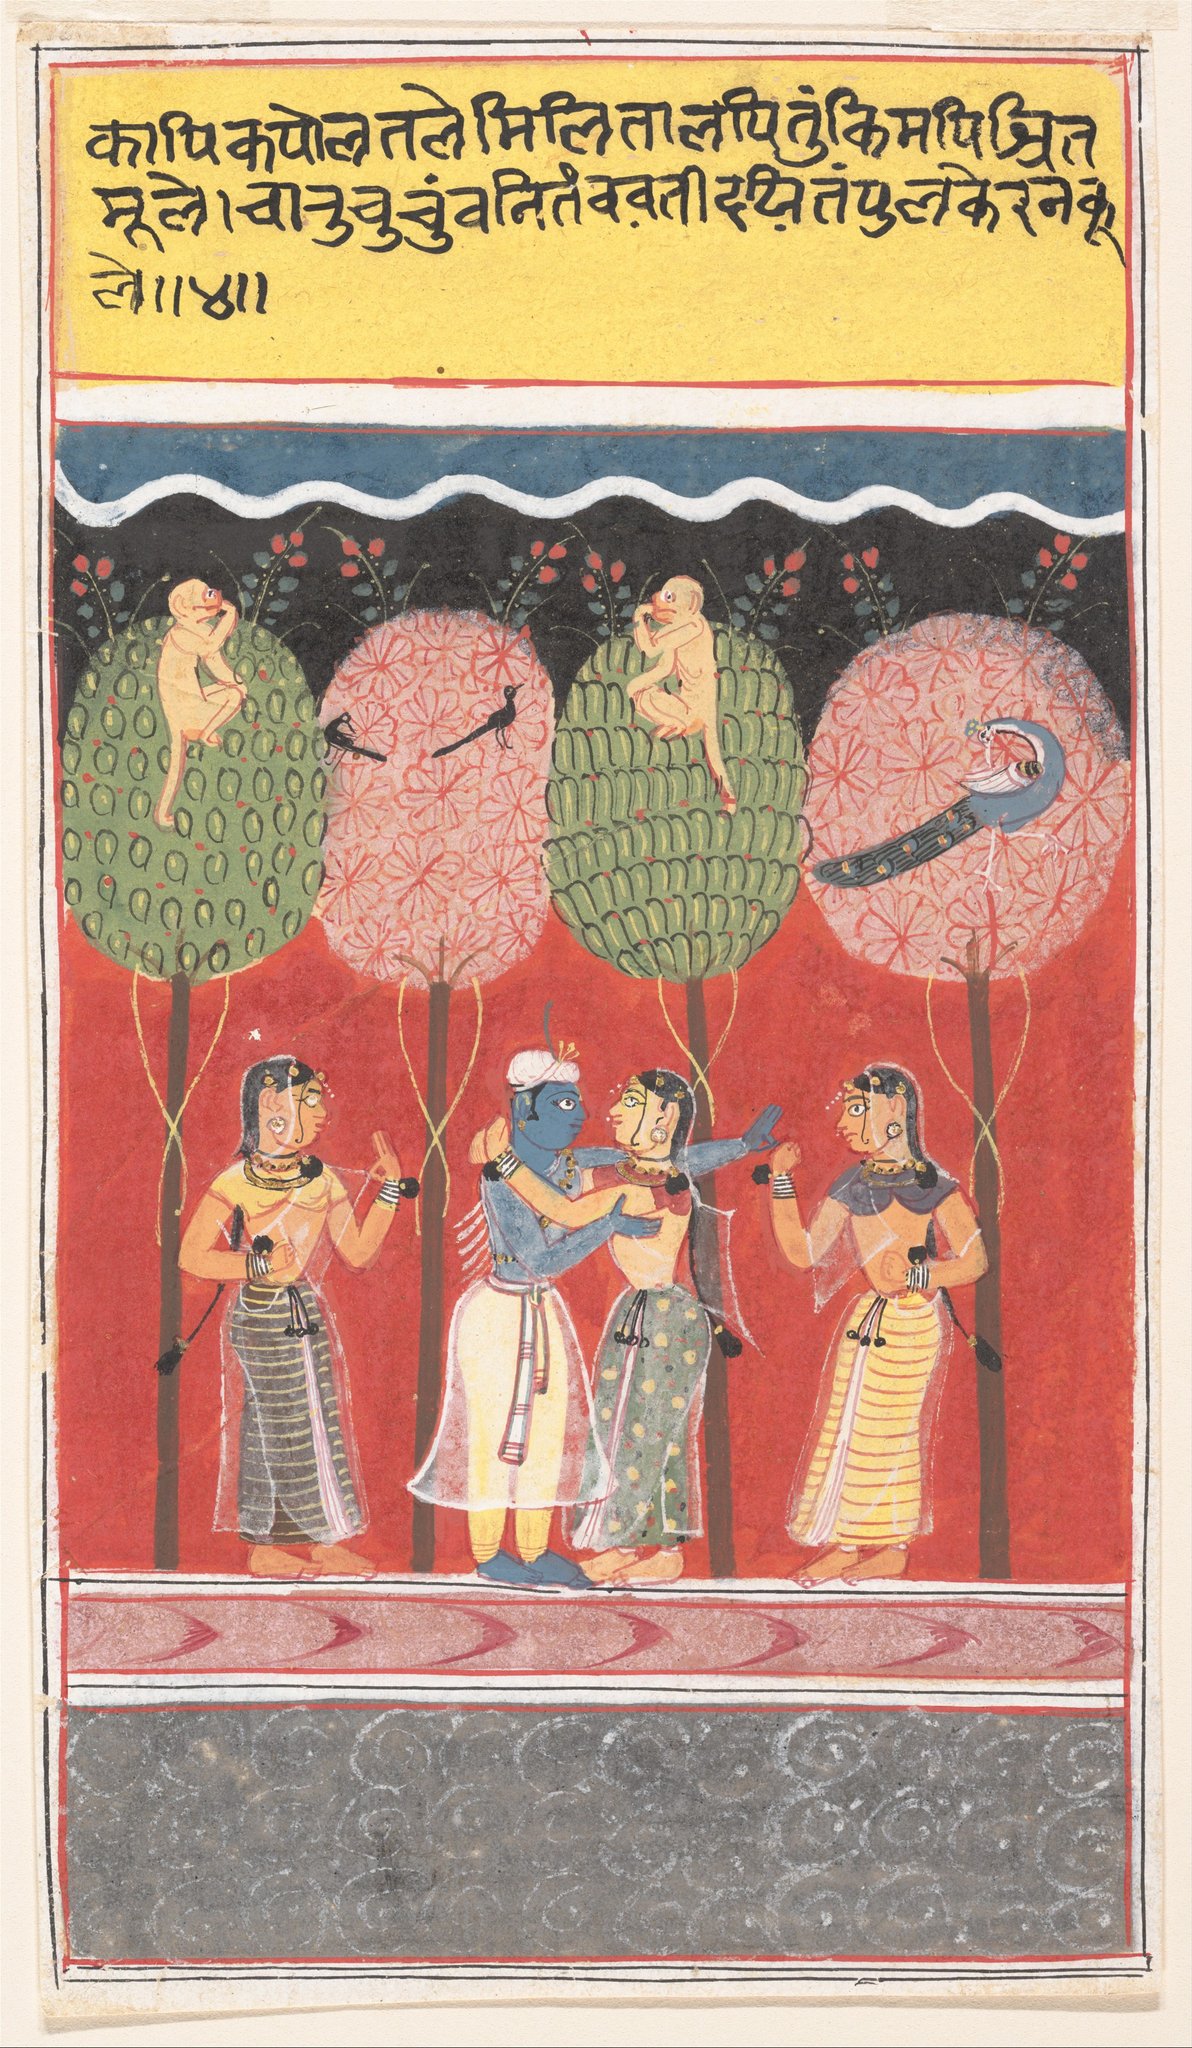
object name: folio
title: Krishna Revels with the Gopis: Page from a Dispersed Gita Govinda (Song of the Cowherds)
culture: indian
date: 1630-1640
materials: paper, silver, watercolor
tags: women,peacocks,monkeys,trees,krishna